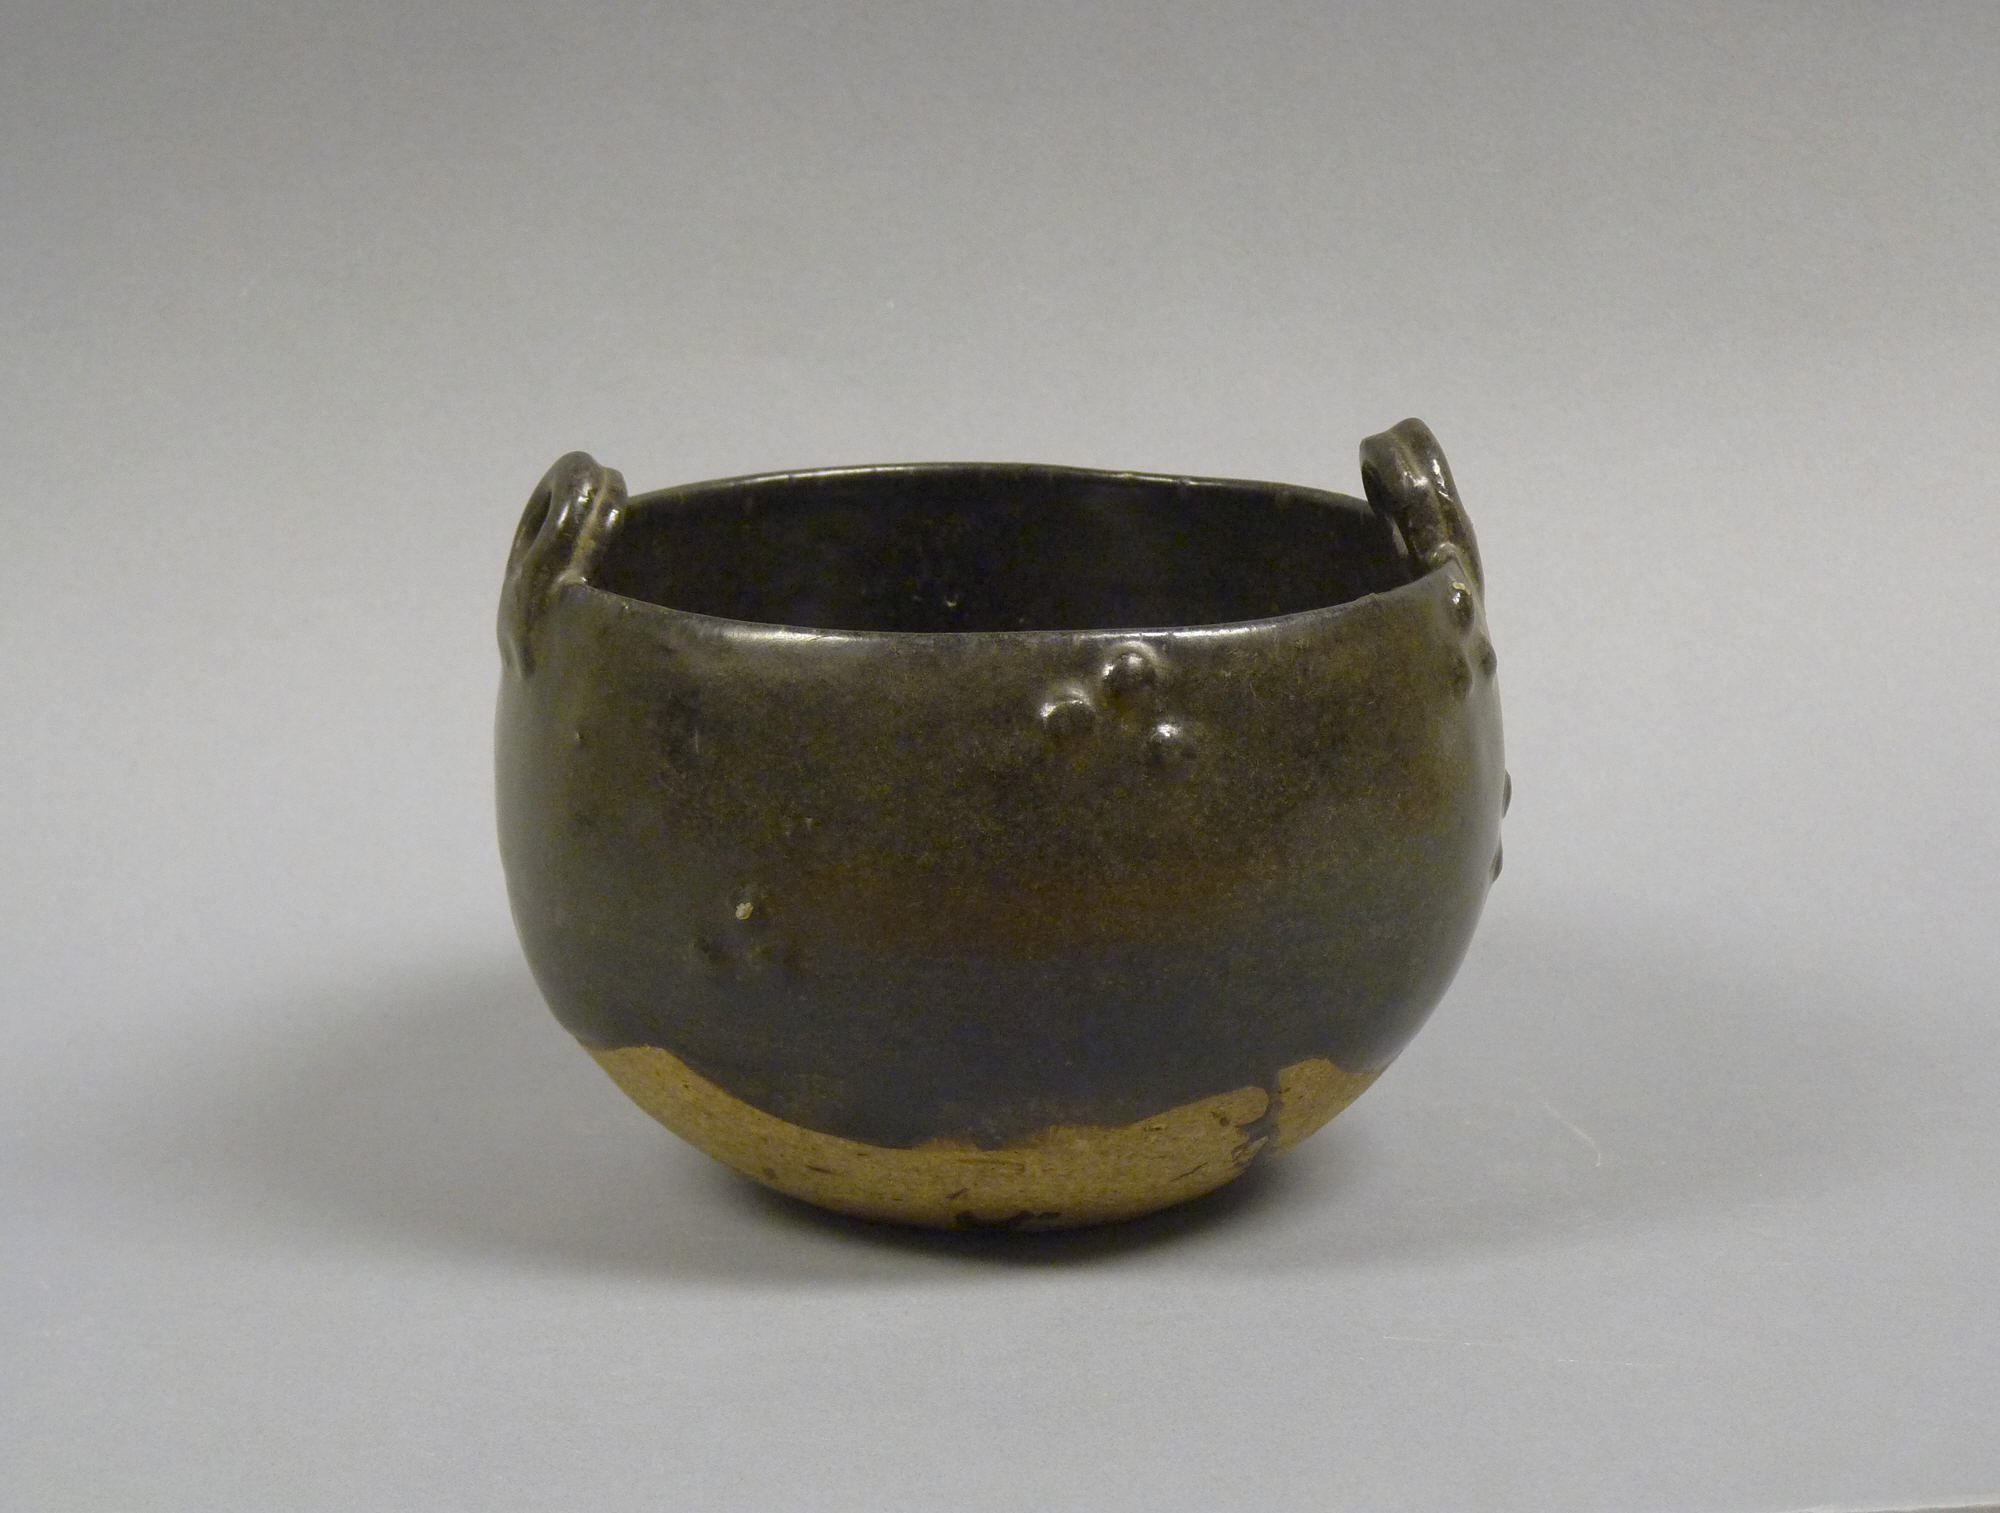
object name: pot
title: Pot with two handles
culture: chinese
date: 1201-1400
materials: earthenware, pottery